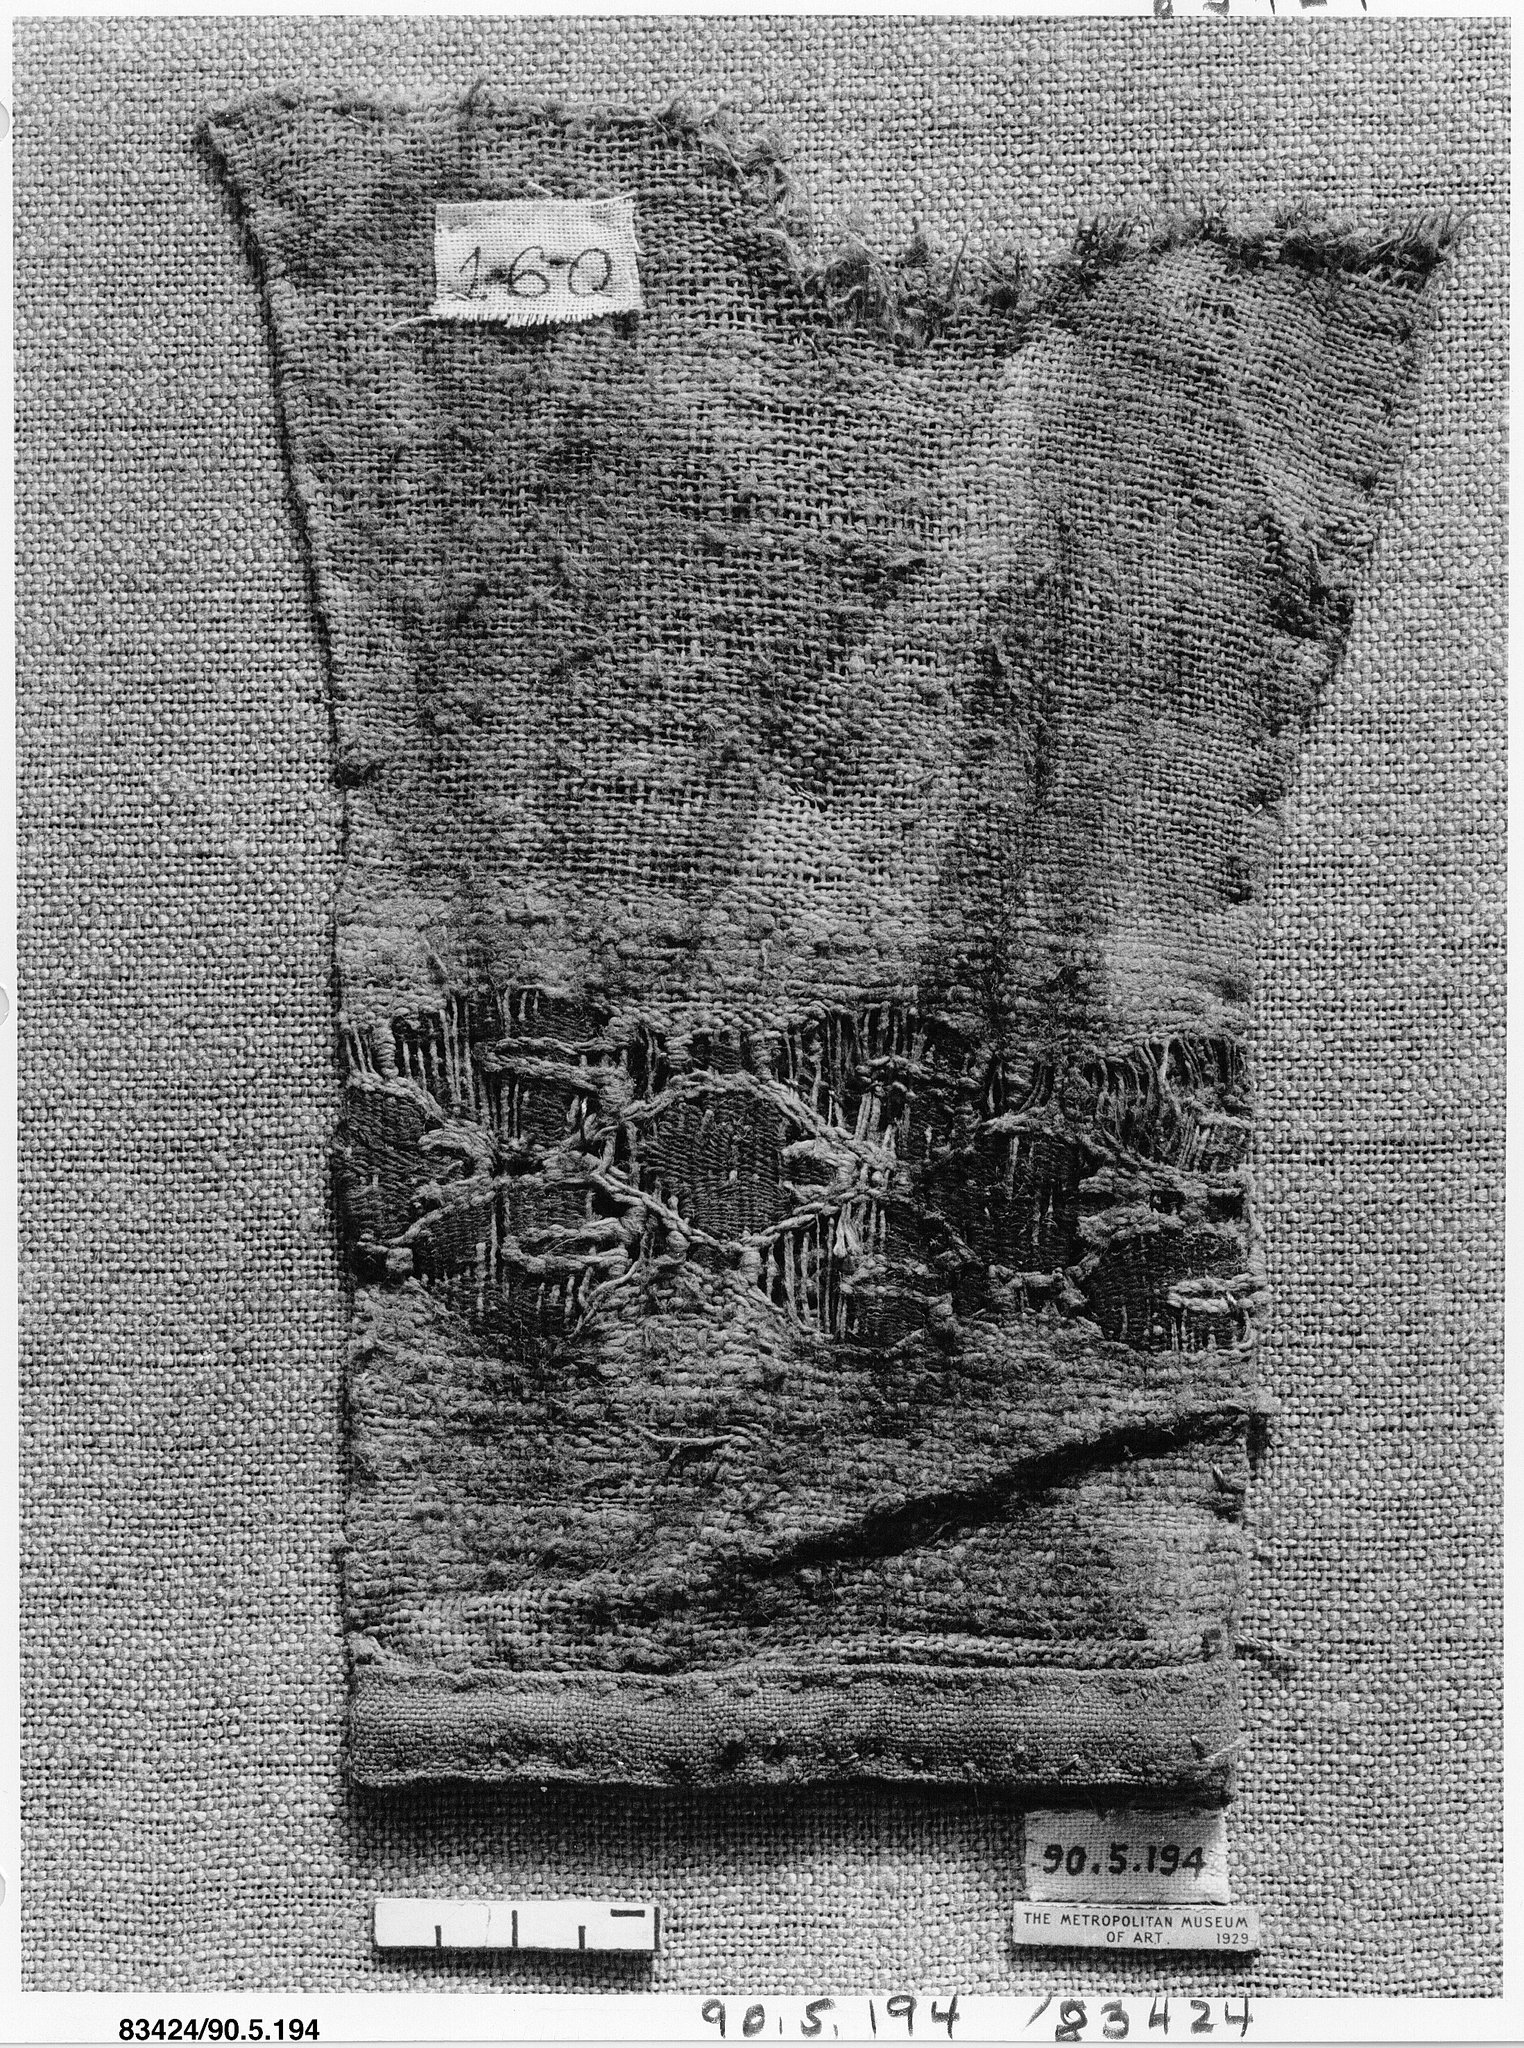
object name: textile fragment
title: Fragment of a Sleeve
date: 401-500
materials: linen, wool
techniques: weave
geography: egypt